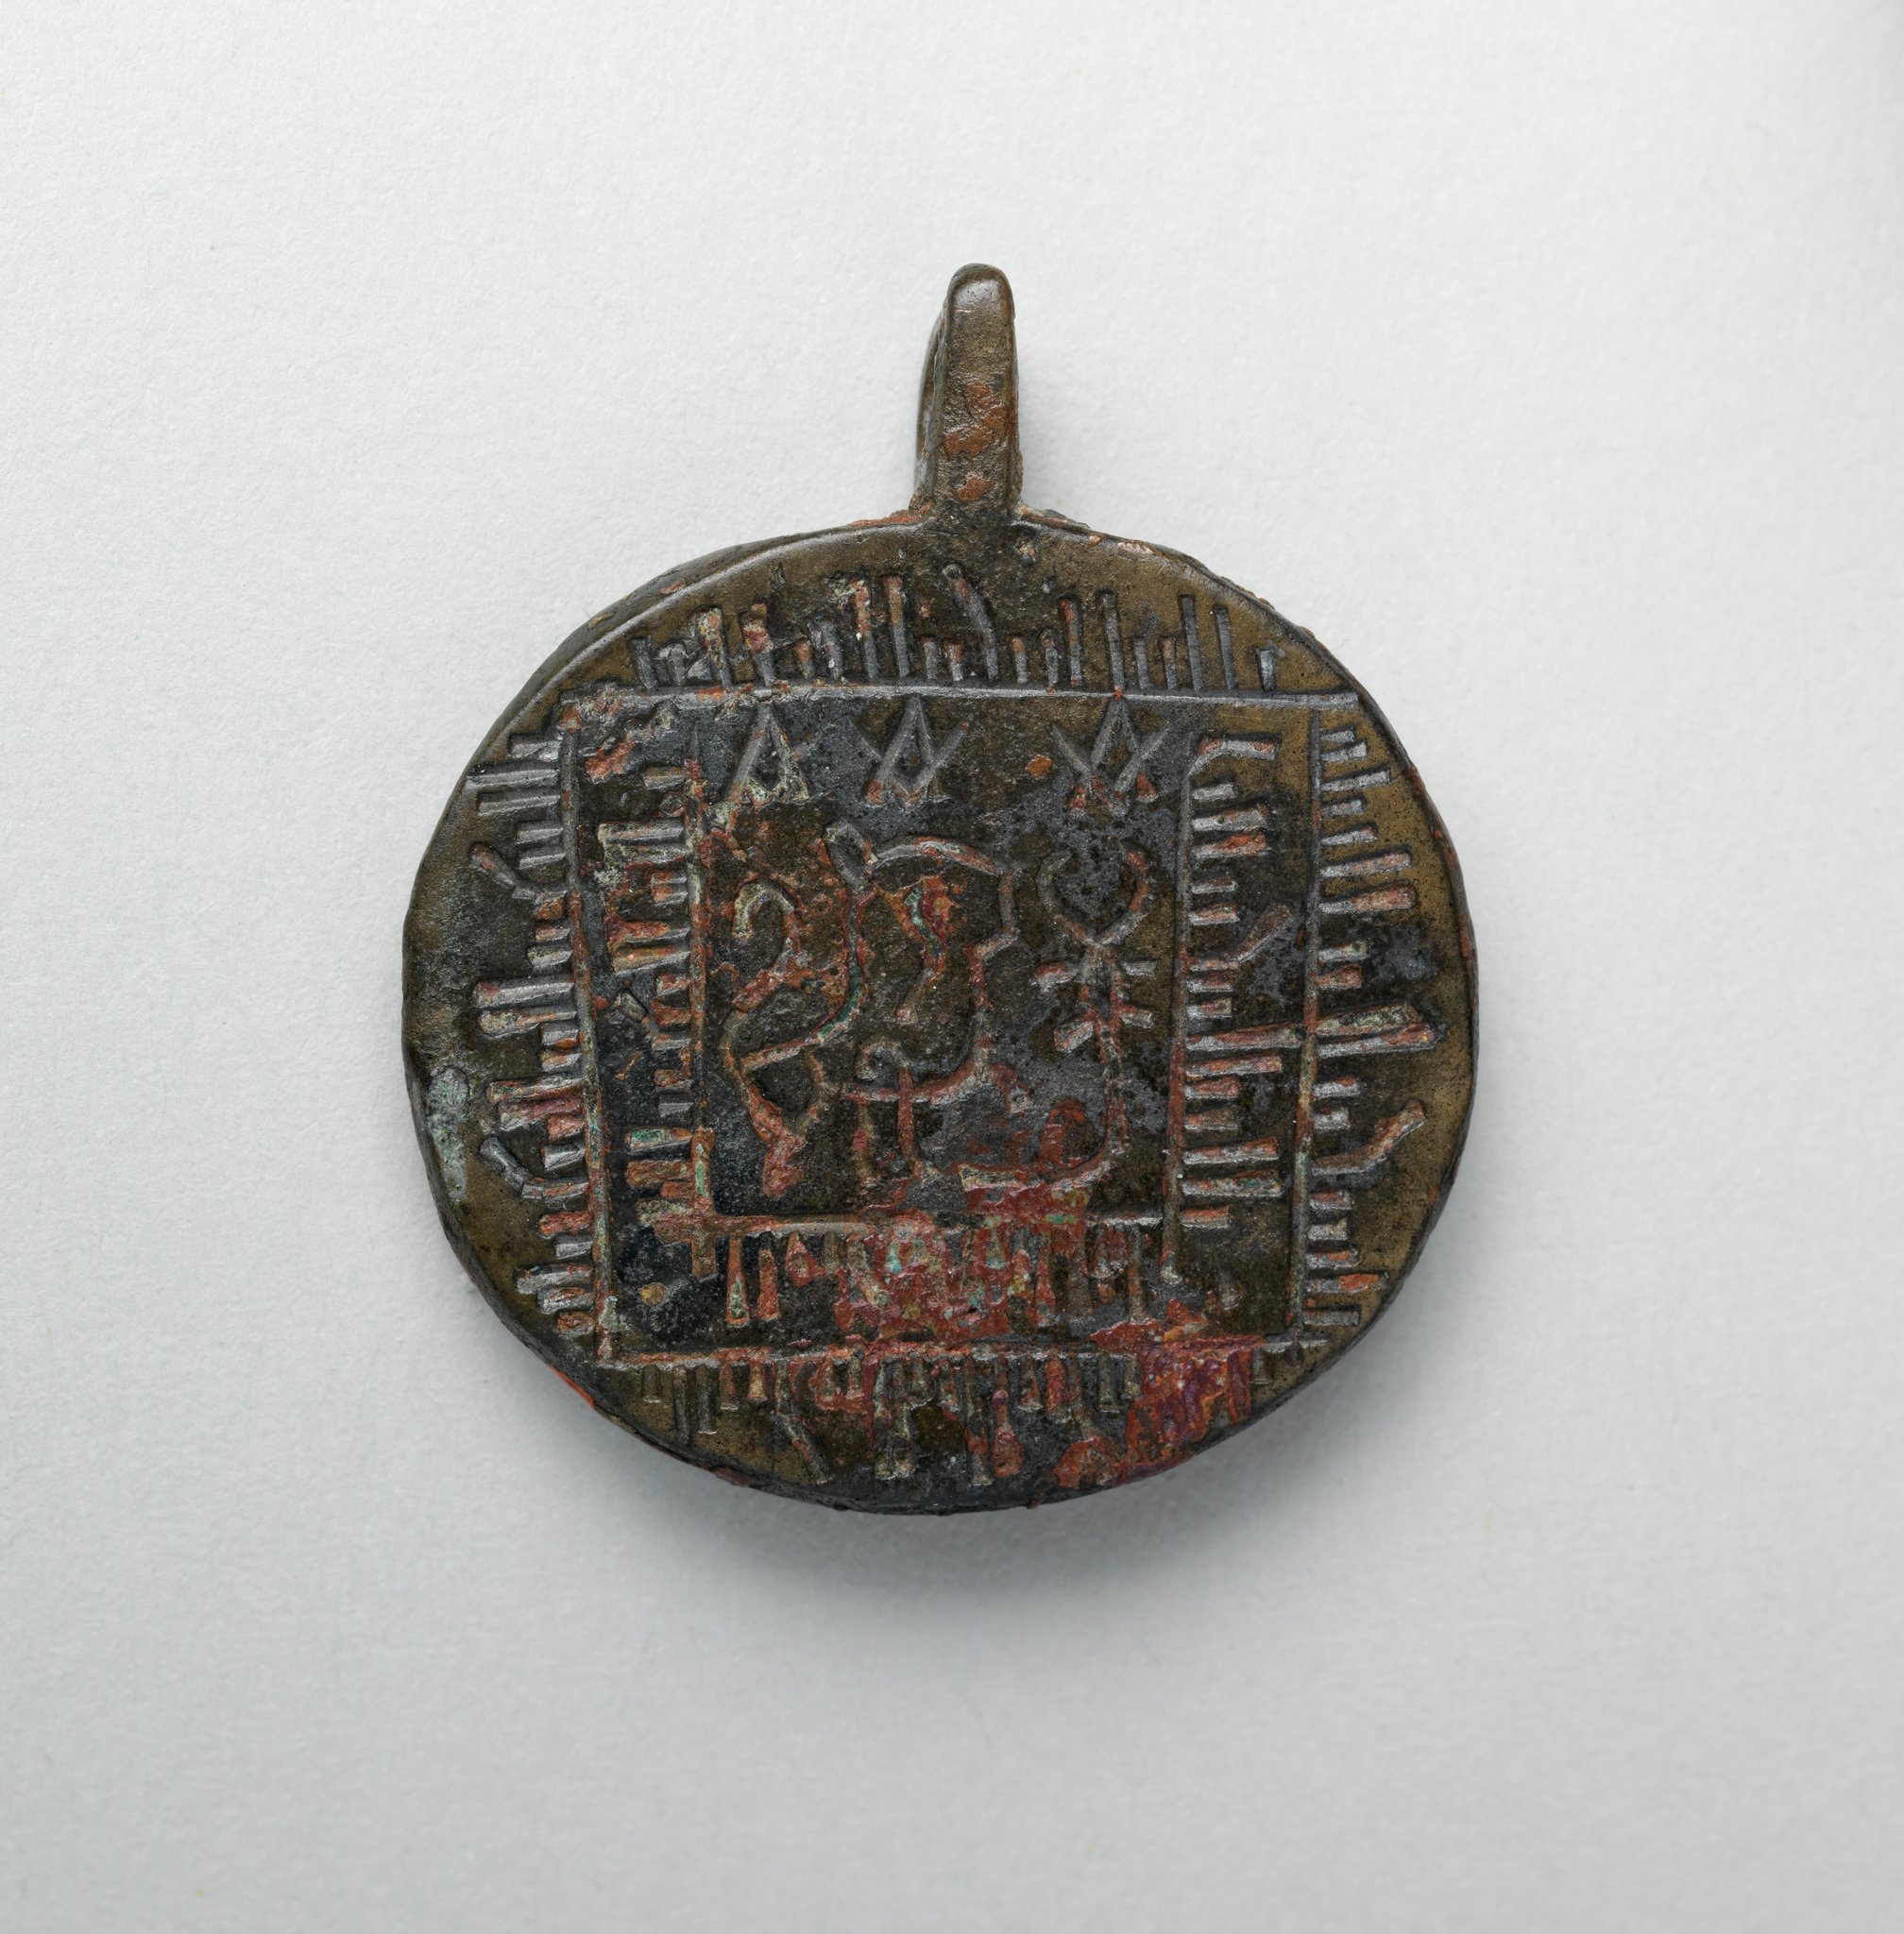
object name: pendant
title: Pendant with Lion and Scorpion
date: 901-1000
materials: bronze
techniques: casting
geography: iran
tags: scorpions,lions